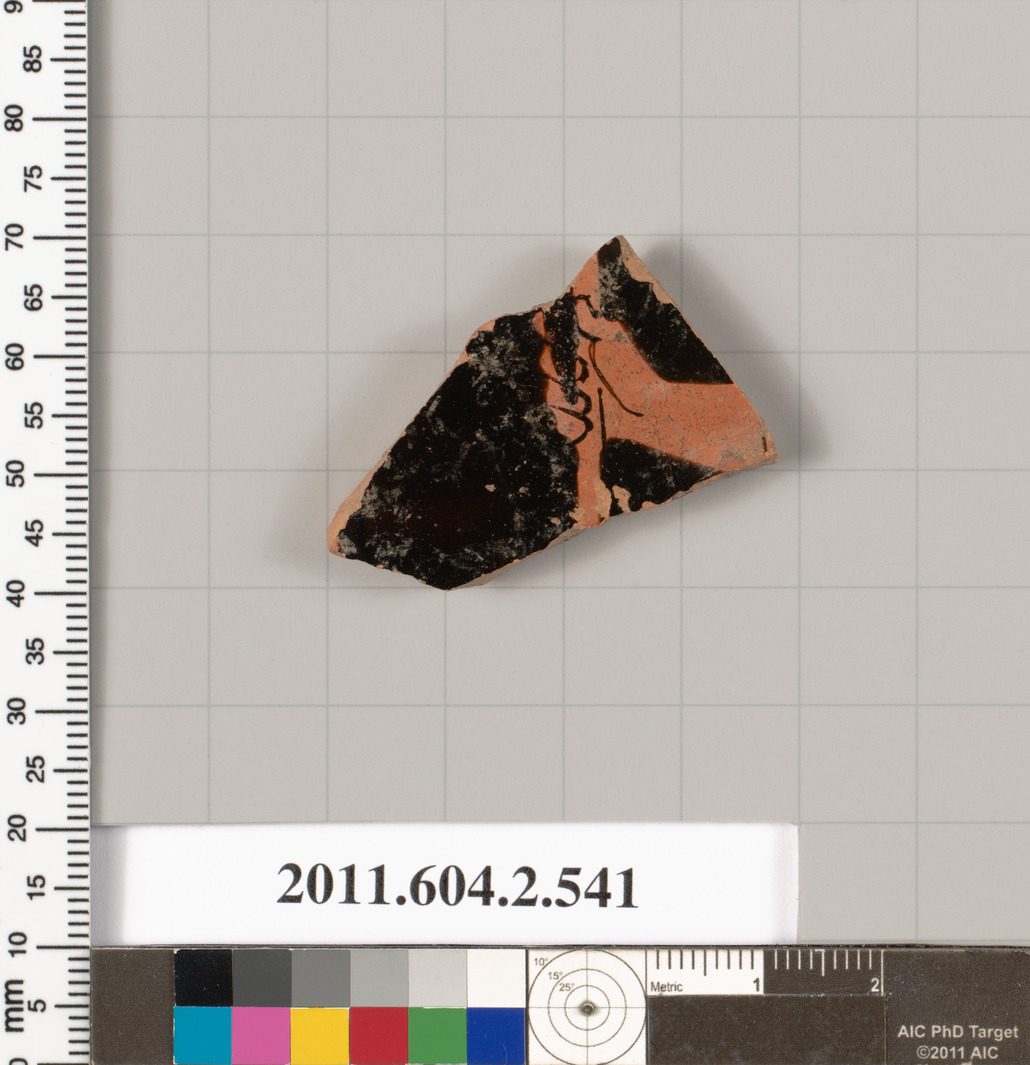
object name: column krater fragment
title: Terracotta fragment of a column-krater (bowl for mixing wine and water)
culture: greek, attic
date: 460-440 BCE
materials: terracotta